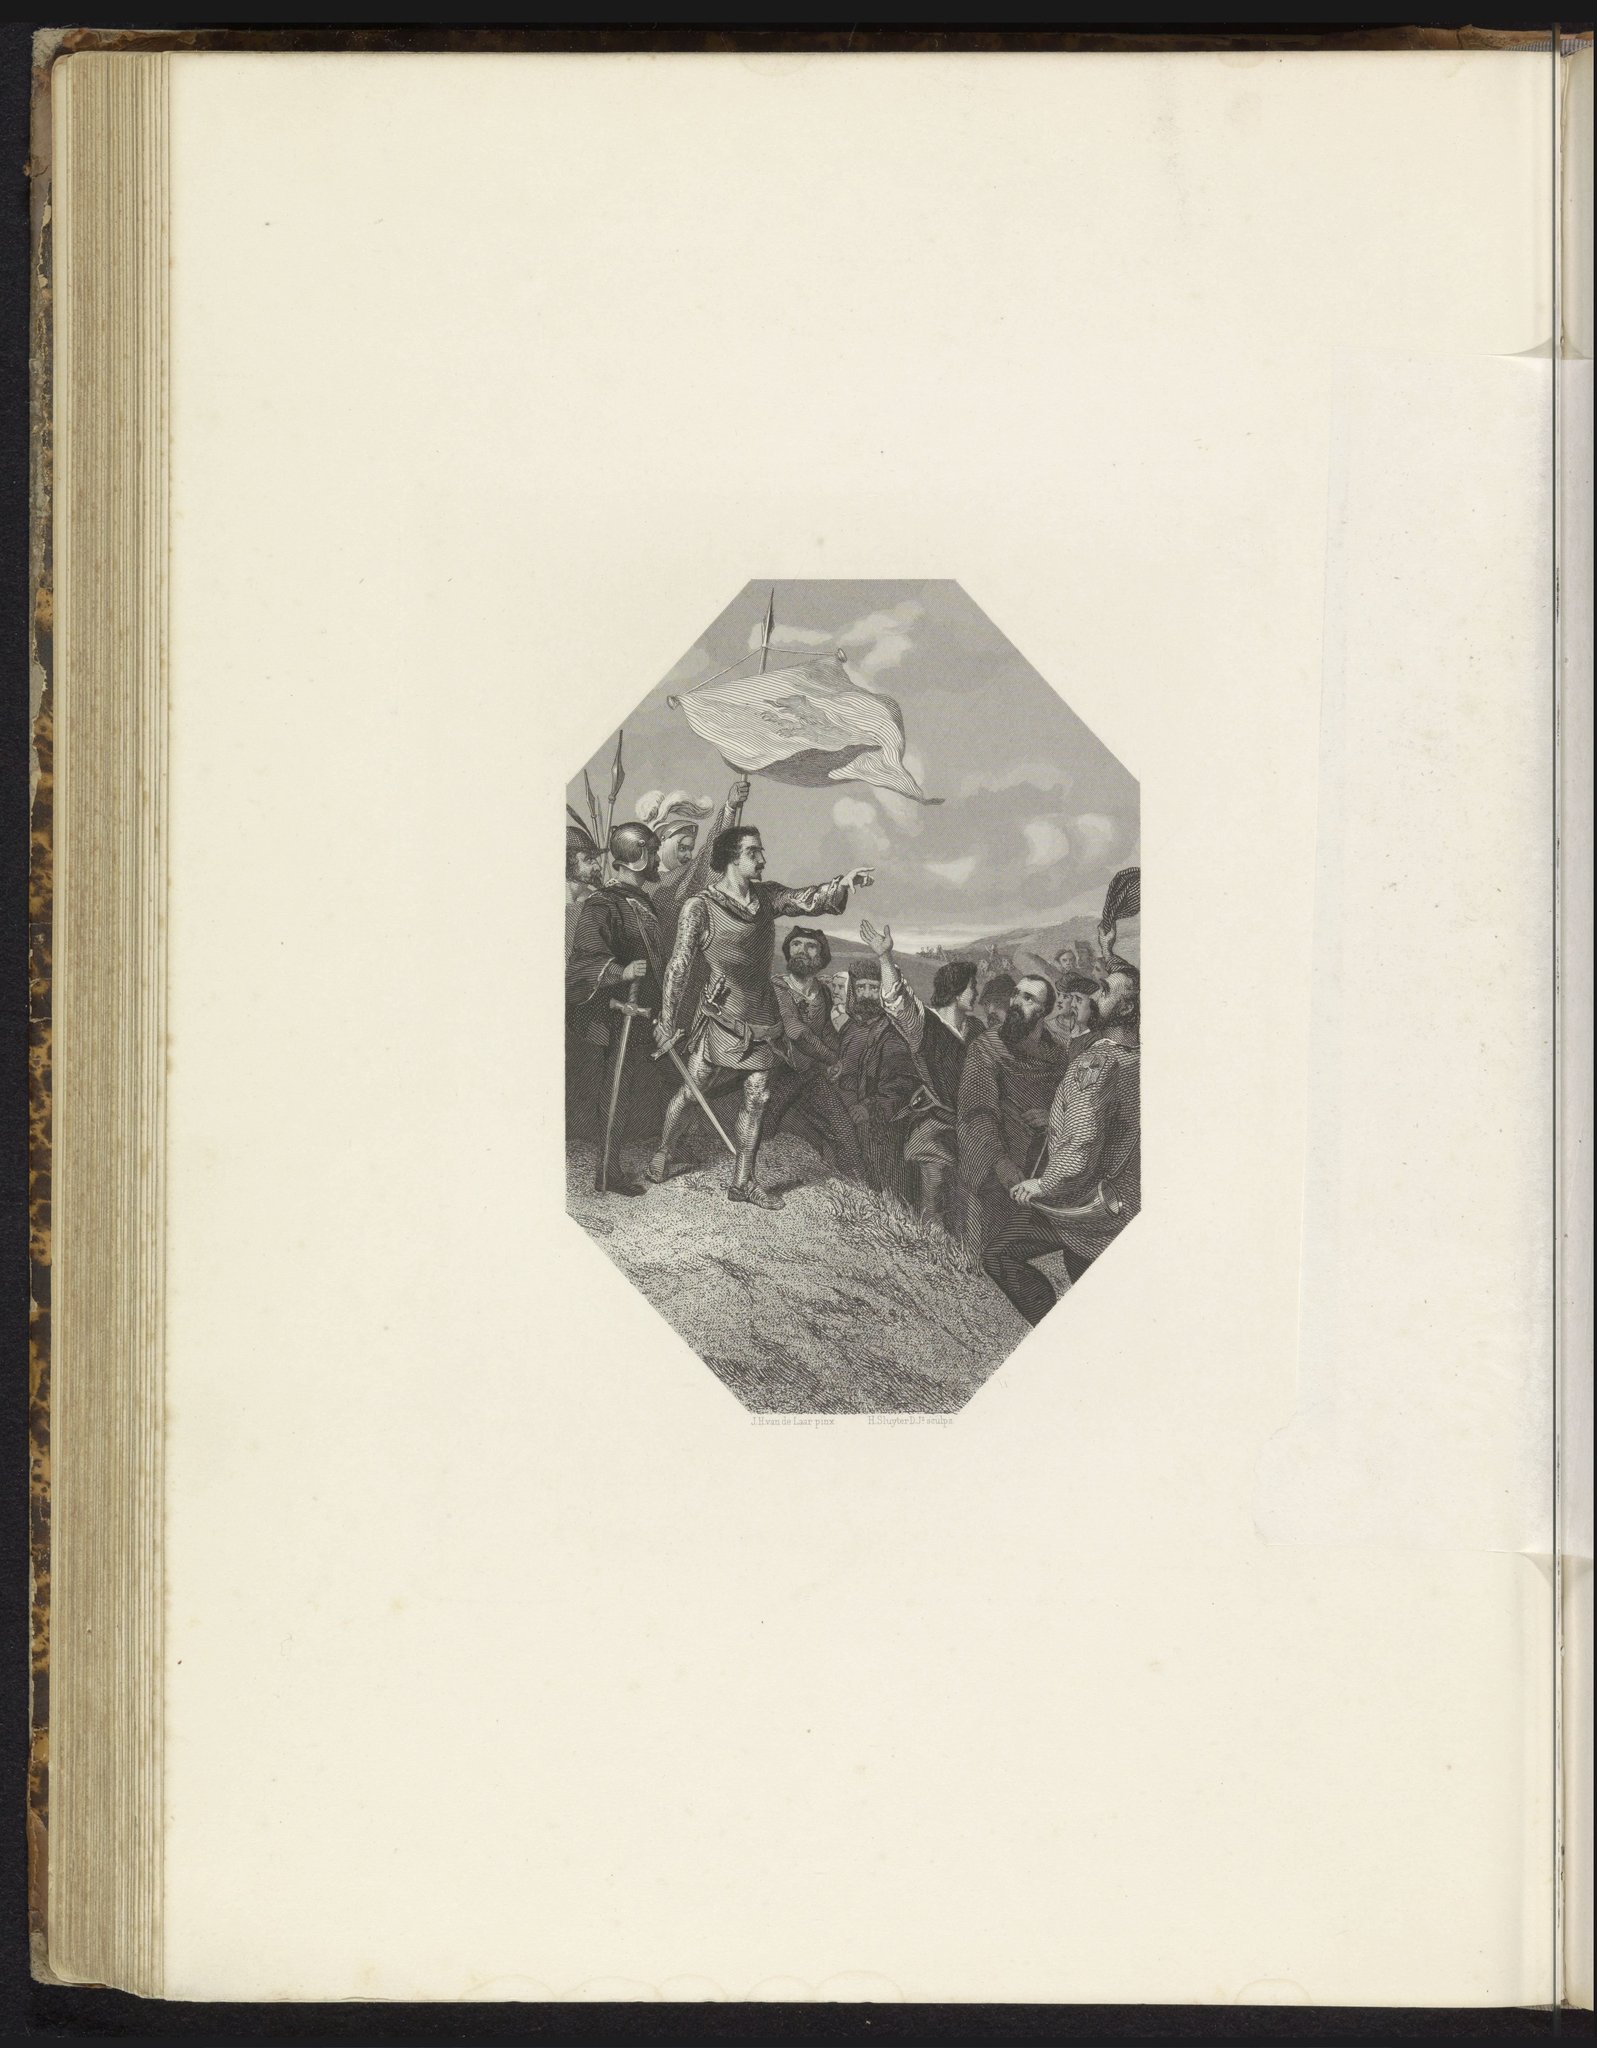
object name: history print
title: Witte van Haamstede op den Blinkert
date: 1865-1870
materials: paper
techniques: engraving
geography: netherlands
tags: battle, fighting in general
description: De ridder Witte van Haemstede plant zijn vlag op de duintop van de Blinkert en leidt het verzet tegen de Vlamingen, 1304. Onderdeel van de groep staalgravures naar de schilderijen van de Historische Galerij der Maatschappij Arti et Amicitiae.